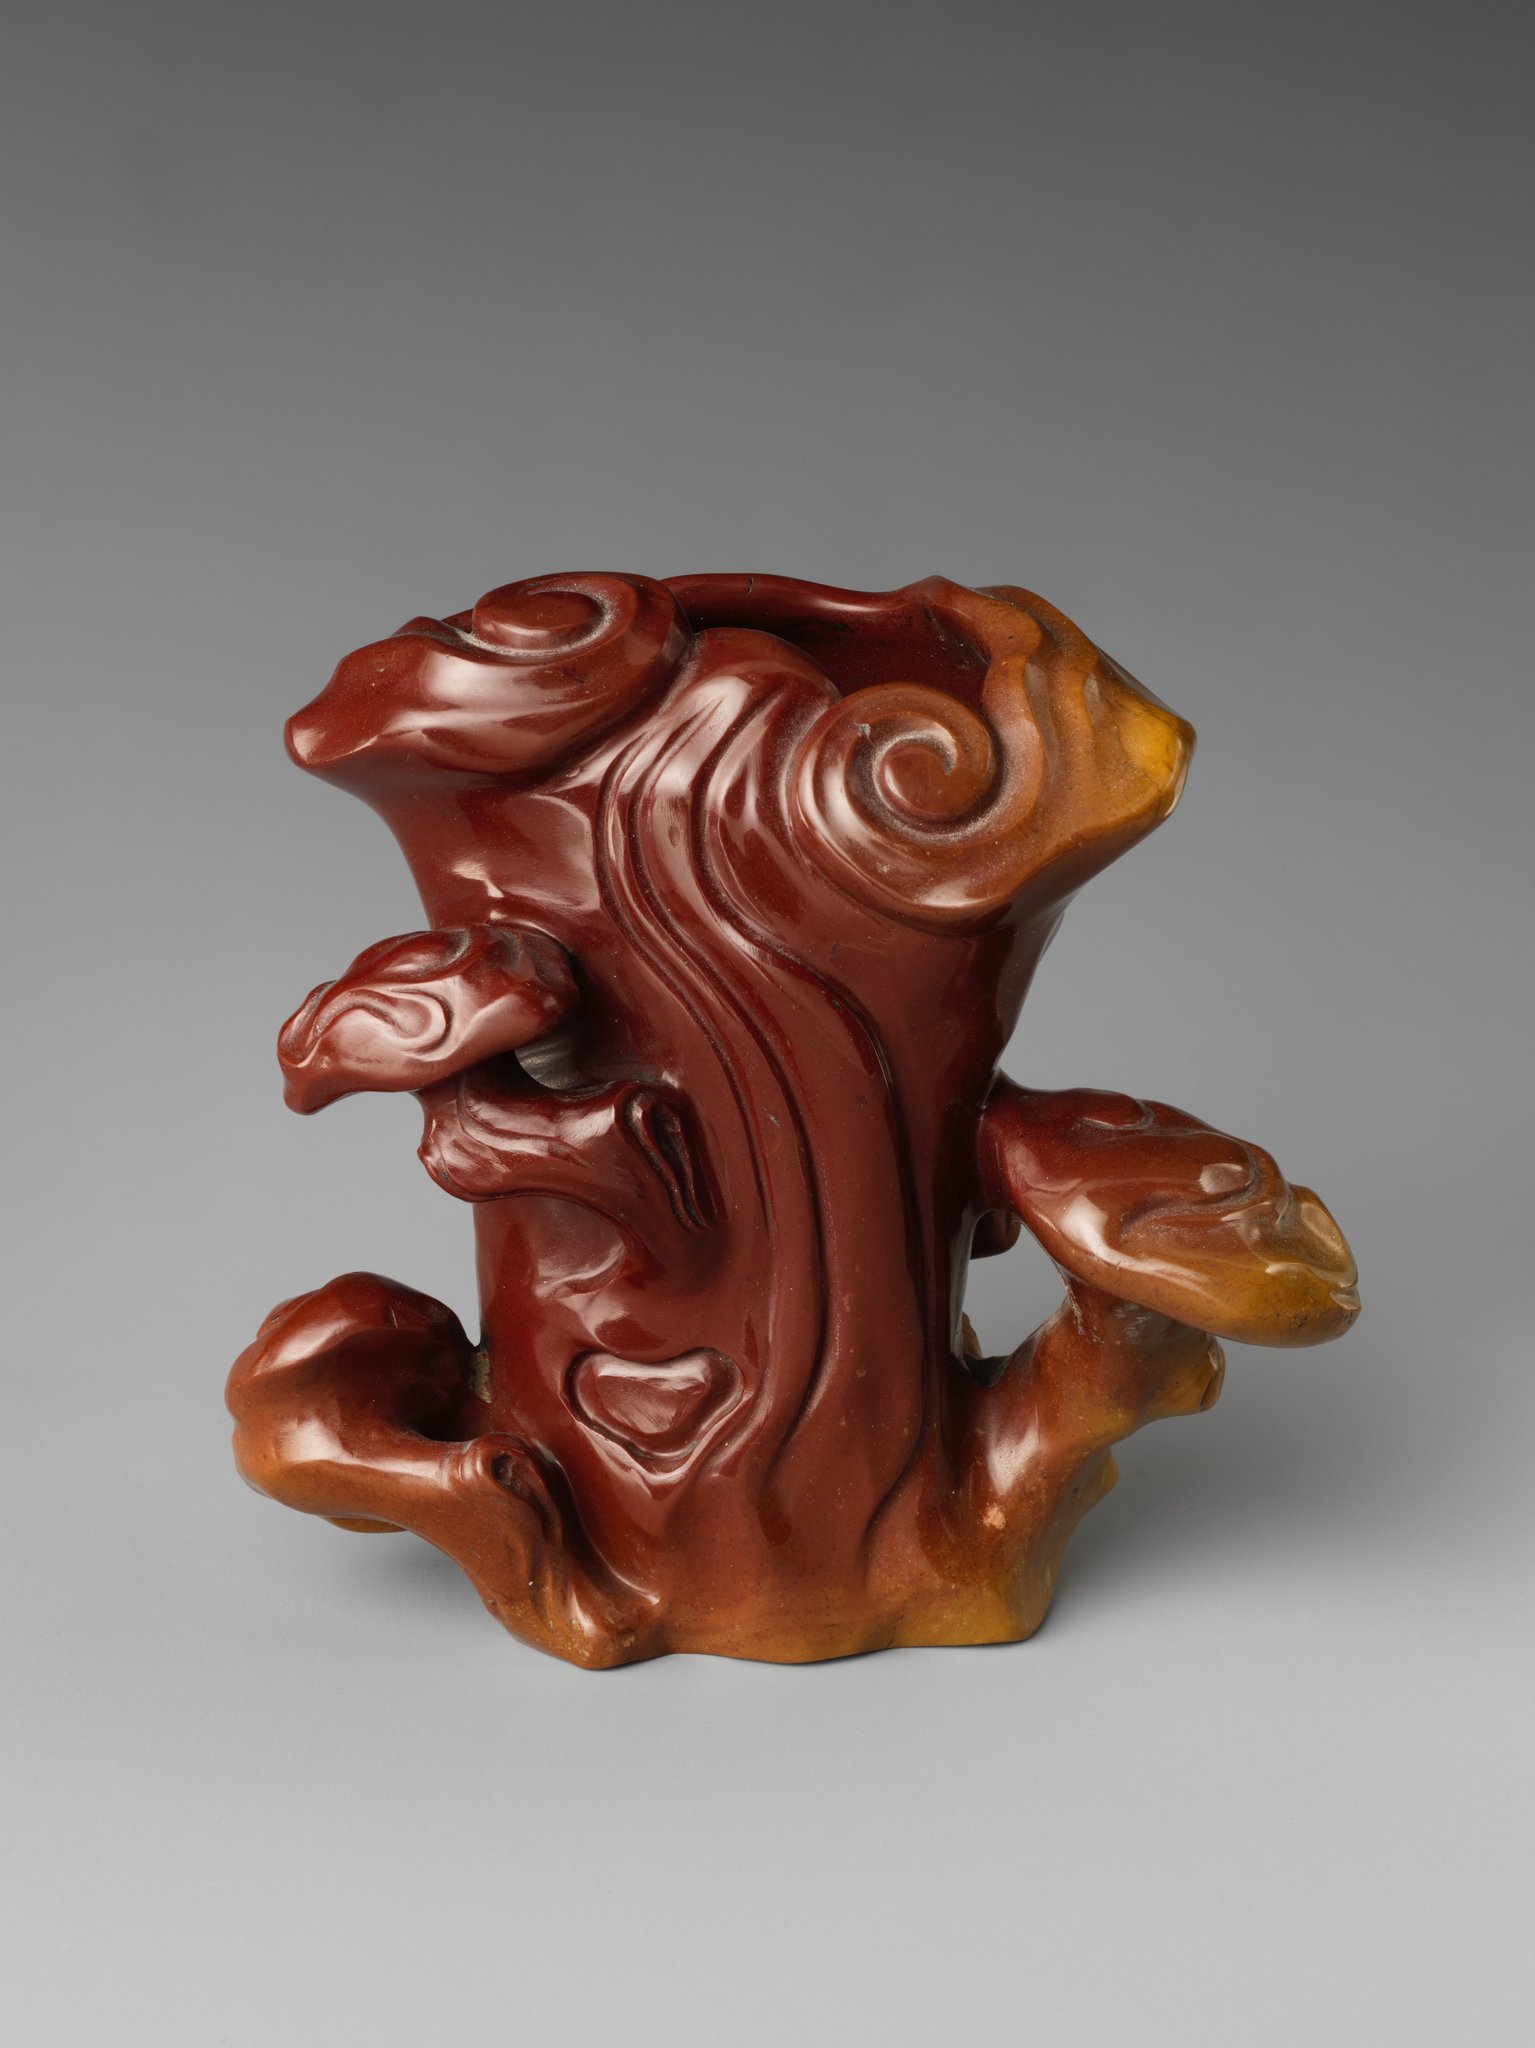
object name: vase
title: Vase with magic fungus (lingzhi)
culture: chinese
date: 1736-1795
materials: jasper